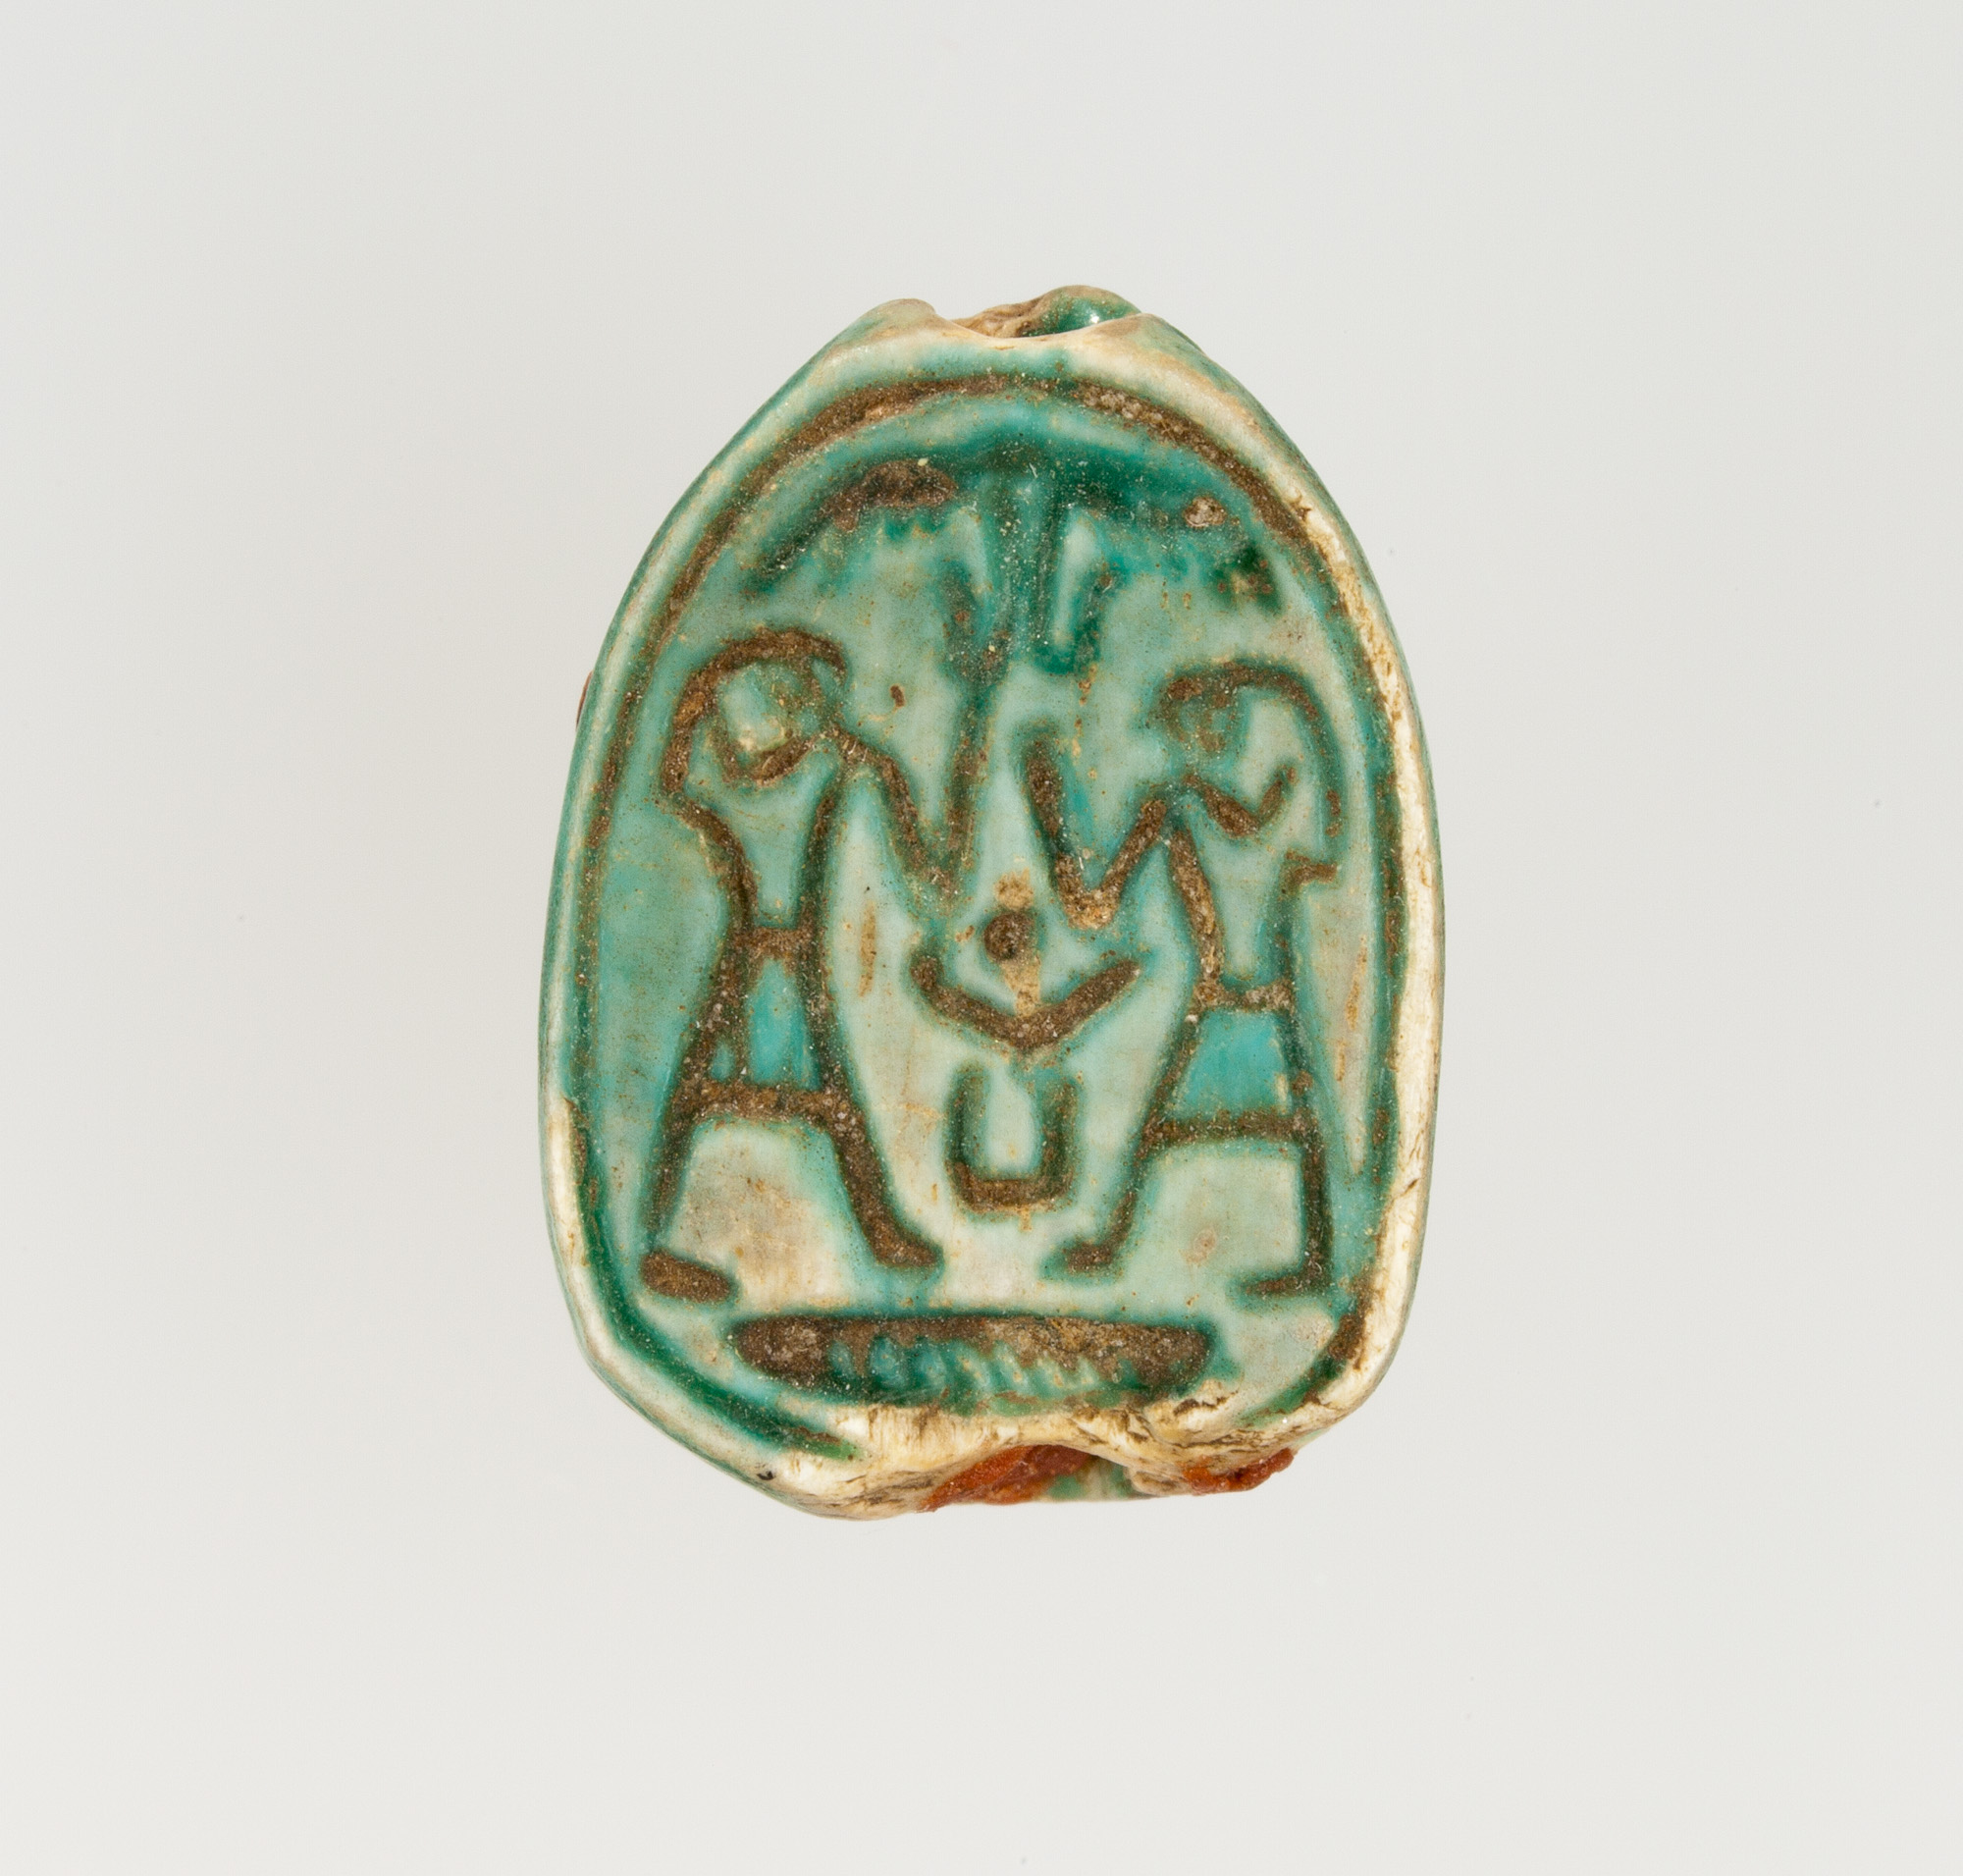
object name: scarab, amenhotep i, djeserkare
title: Scarab Inscribed with the Throne Name of Amenhotep I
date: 1525-1504 BCE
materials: stone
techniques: glazing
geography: egypt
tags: human figures,scarabs